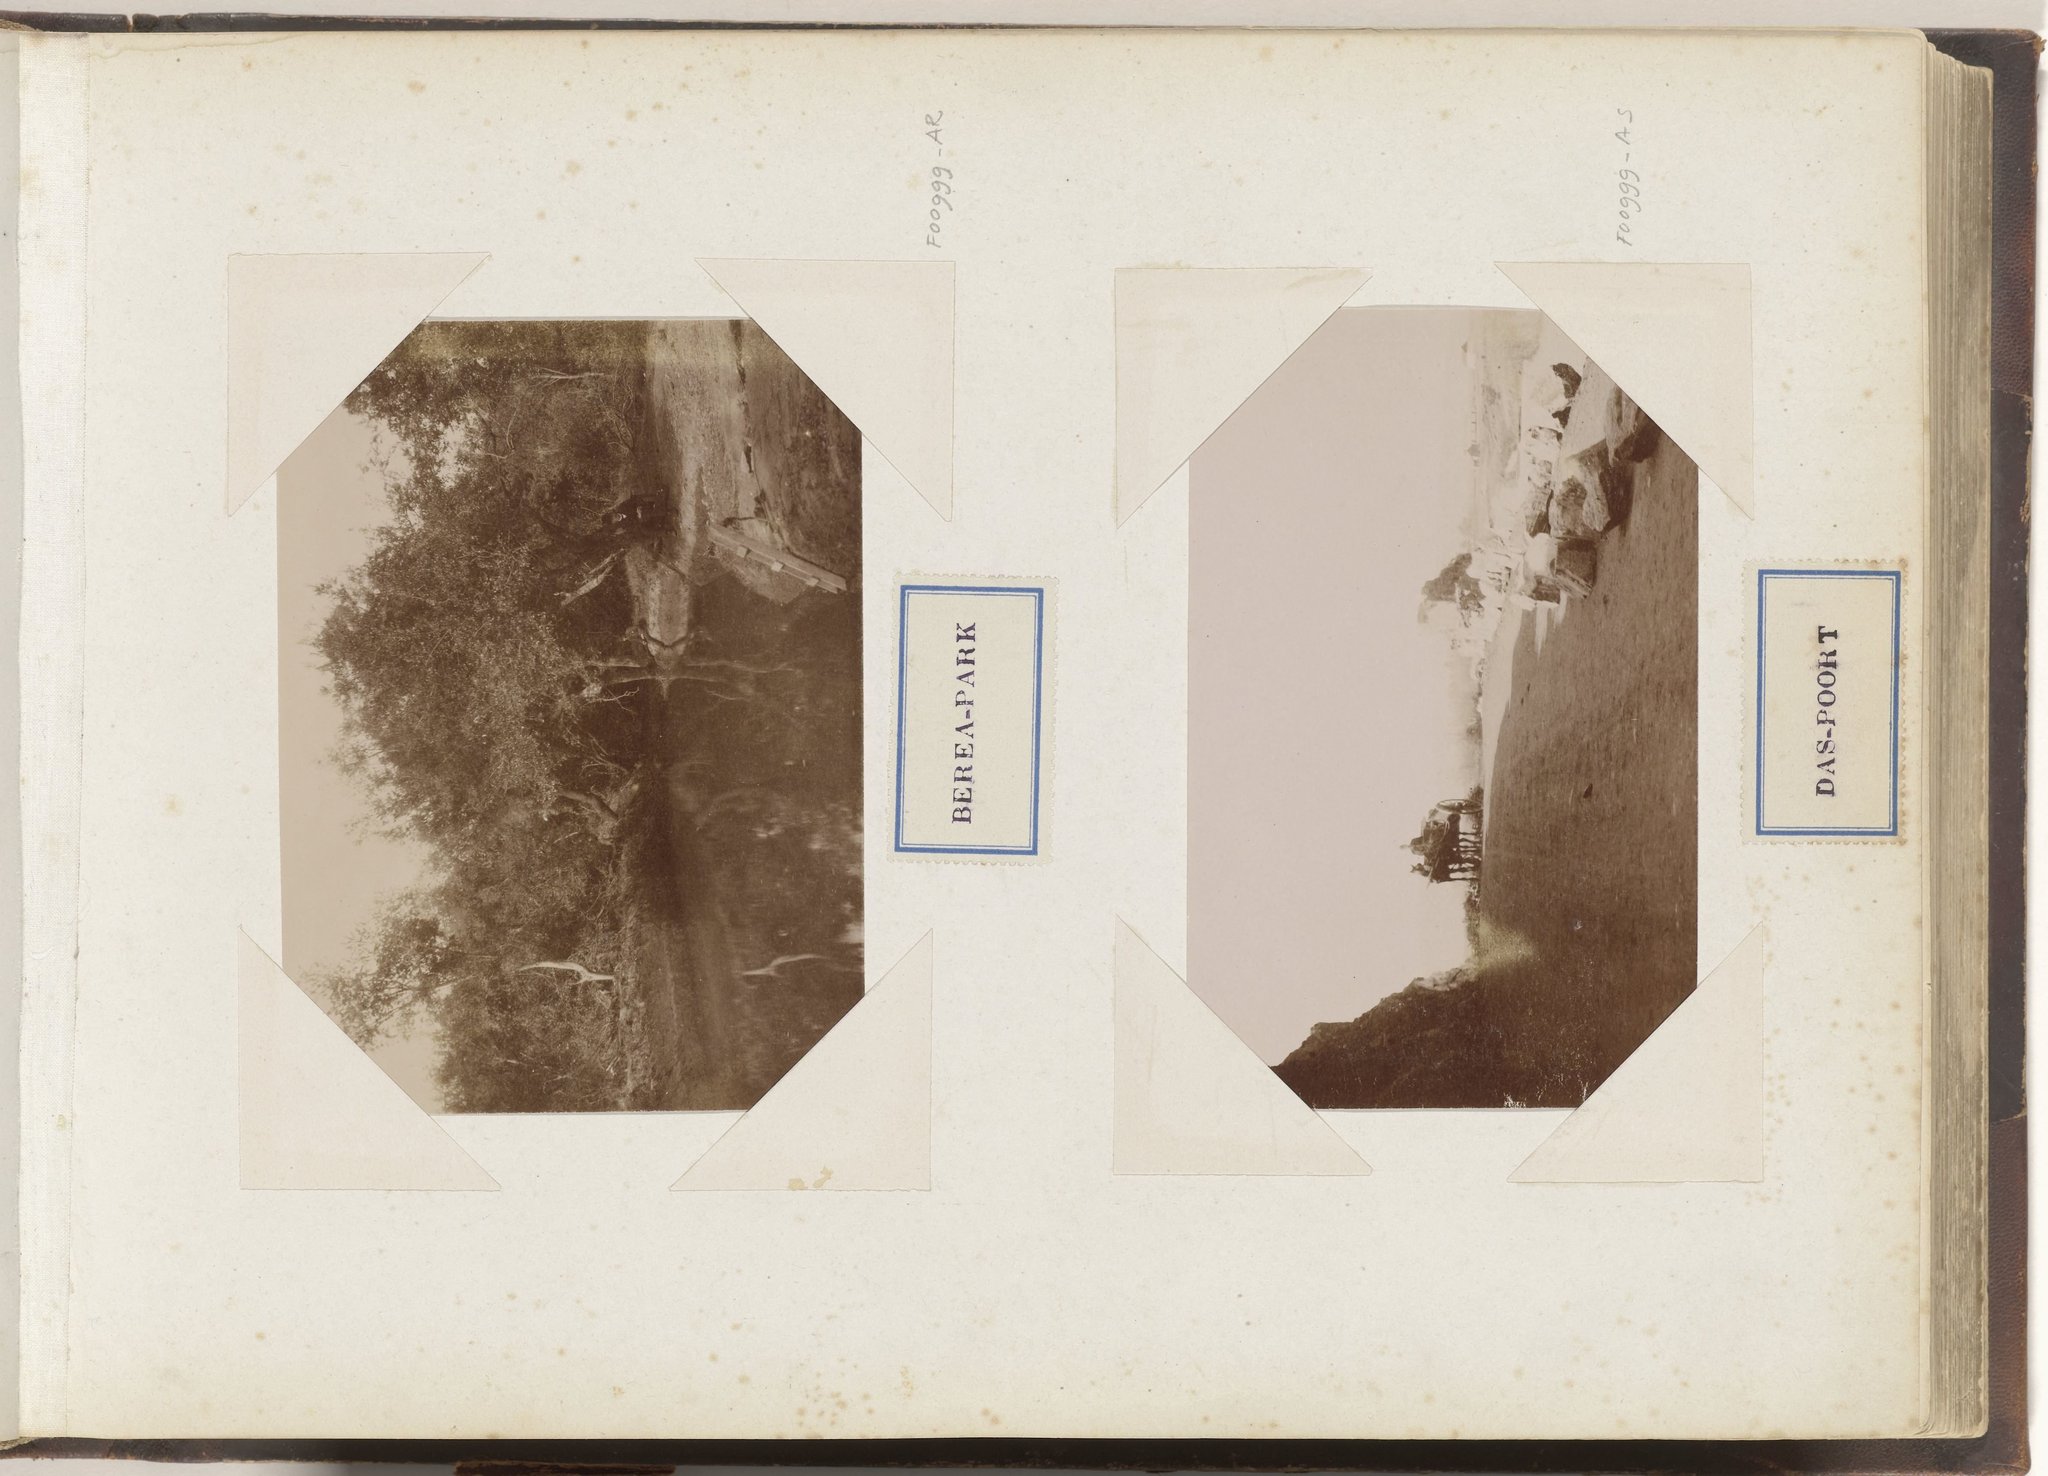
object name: photograph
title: Mannen onder boom in Berea-park in Zuid-Afrika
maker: Anonymous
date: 1885-1910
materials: paper, photographic support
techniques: collodion silver print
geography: south africa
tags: public gardens, park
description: Onderdeel van Album met 191 foto's van een reis naar en door Zuid-Afrika.